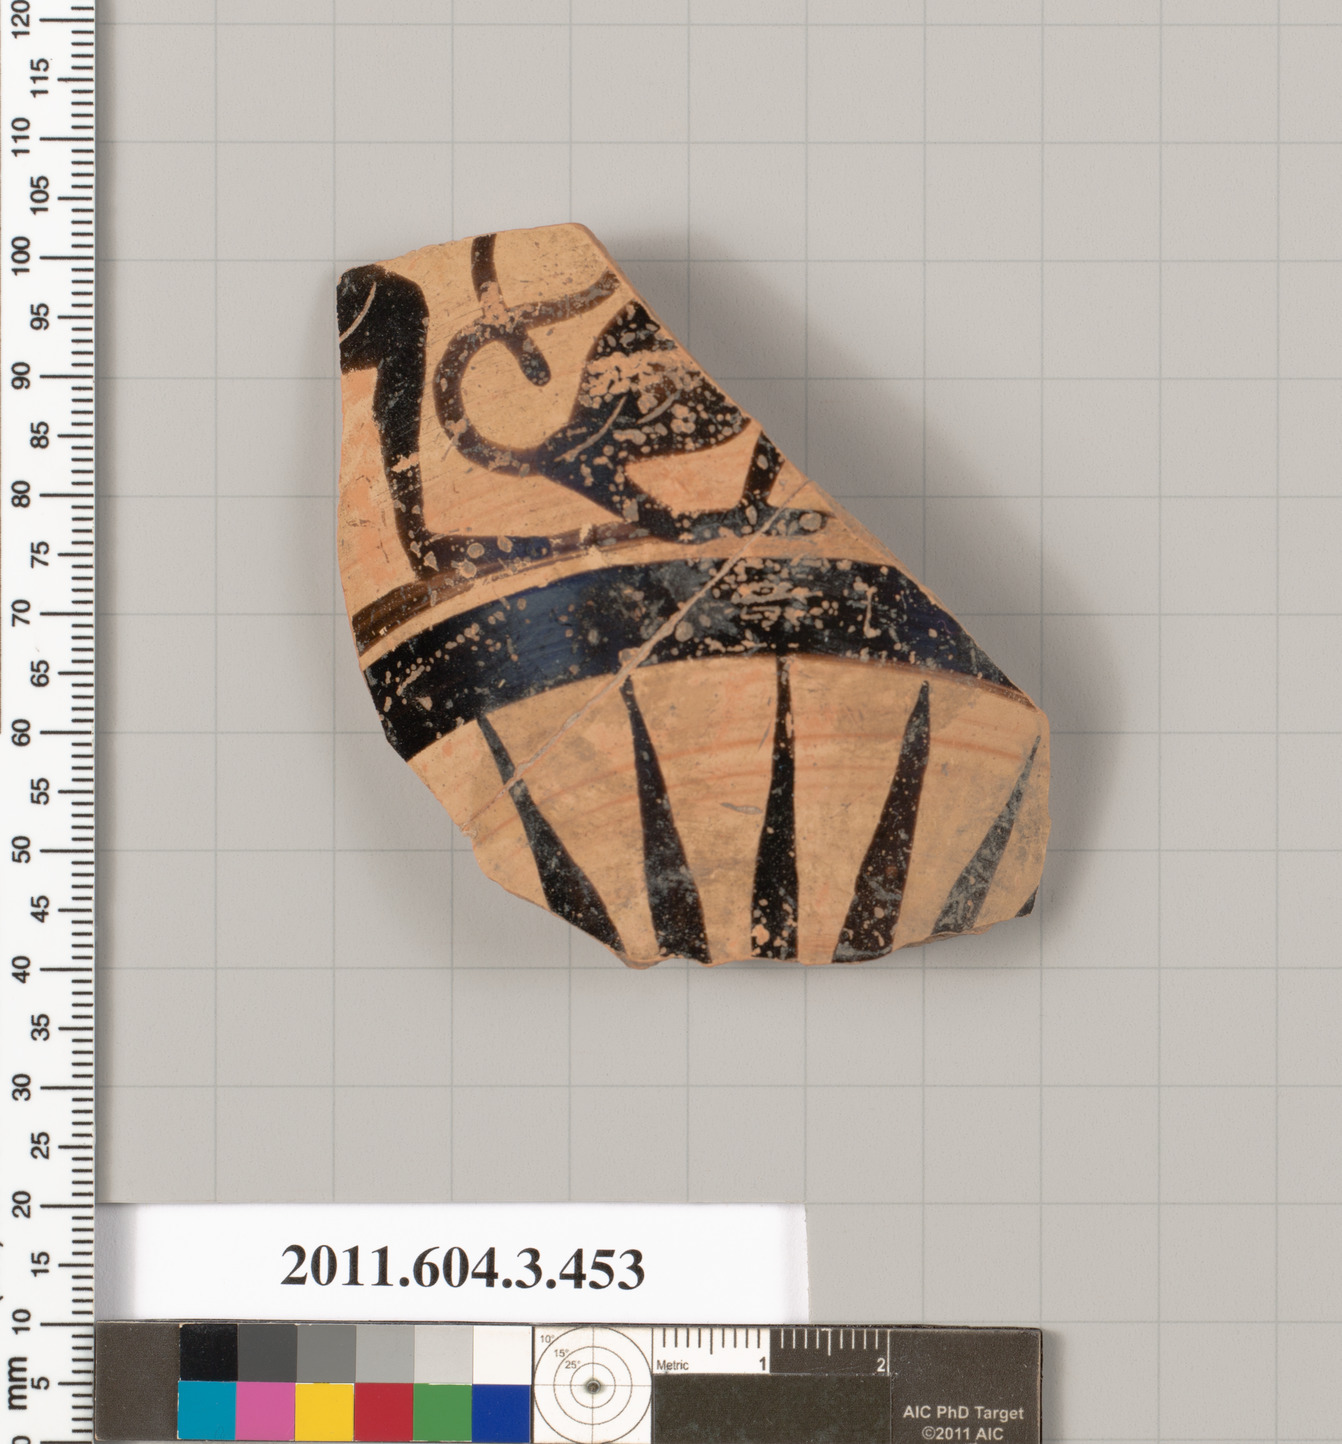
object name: neck amphora fragment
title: Terracotta fragment of a neck-amphora (jar)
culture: greek, attic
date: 490-480 BCE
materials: terracotta